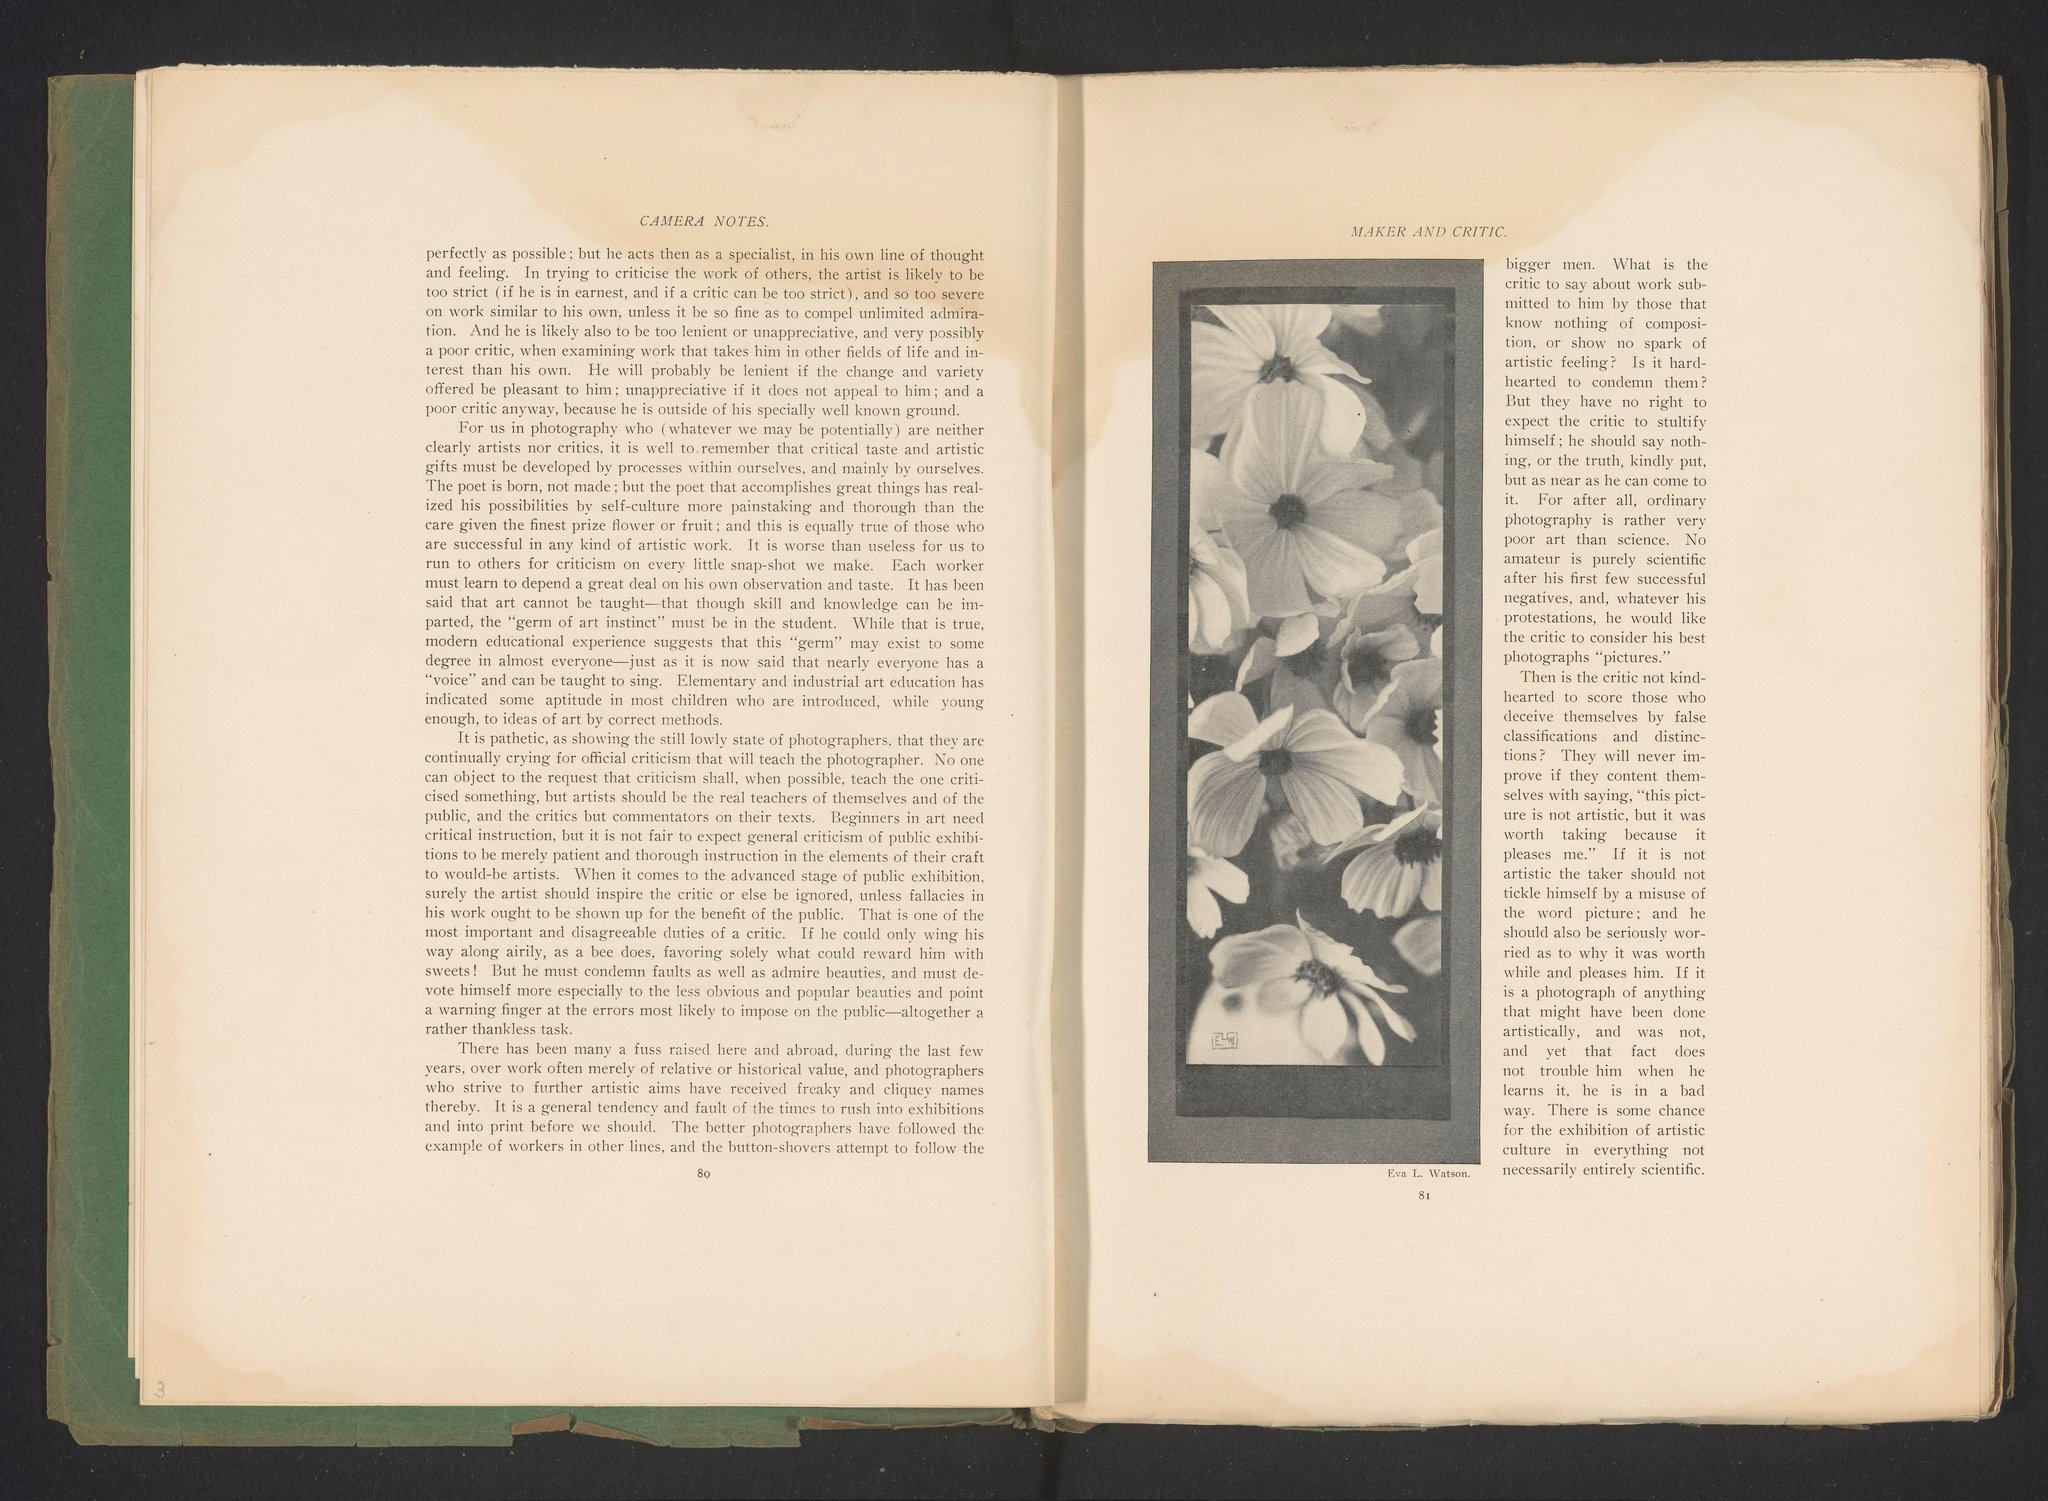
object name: photomechanical print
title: Bloemen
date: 1895-1900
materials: paper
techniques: autotype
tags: flowers